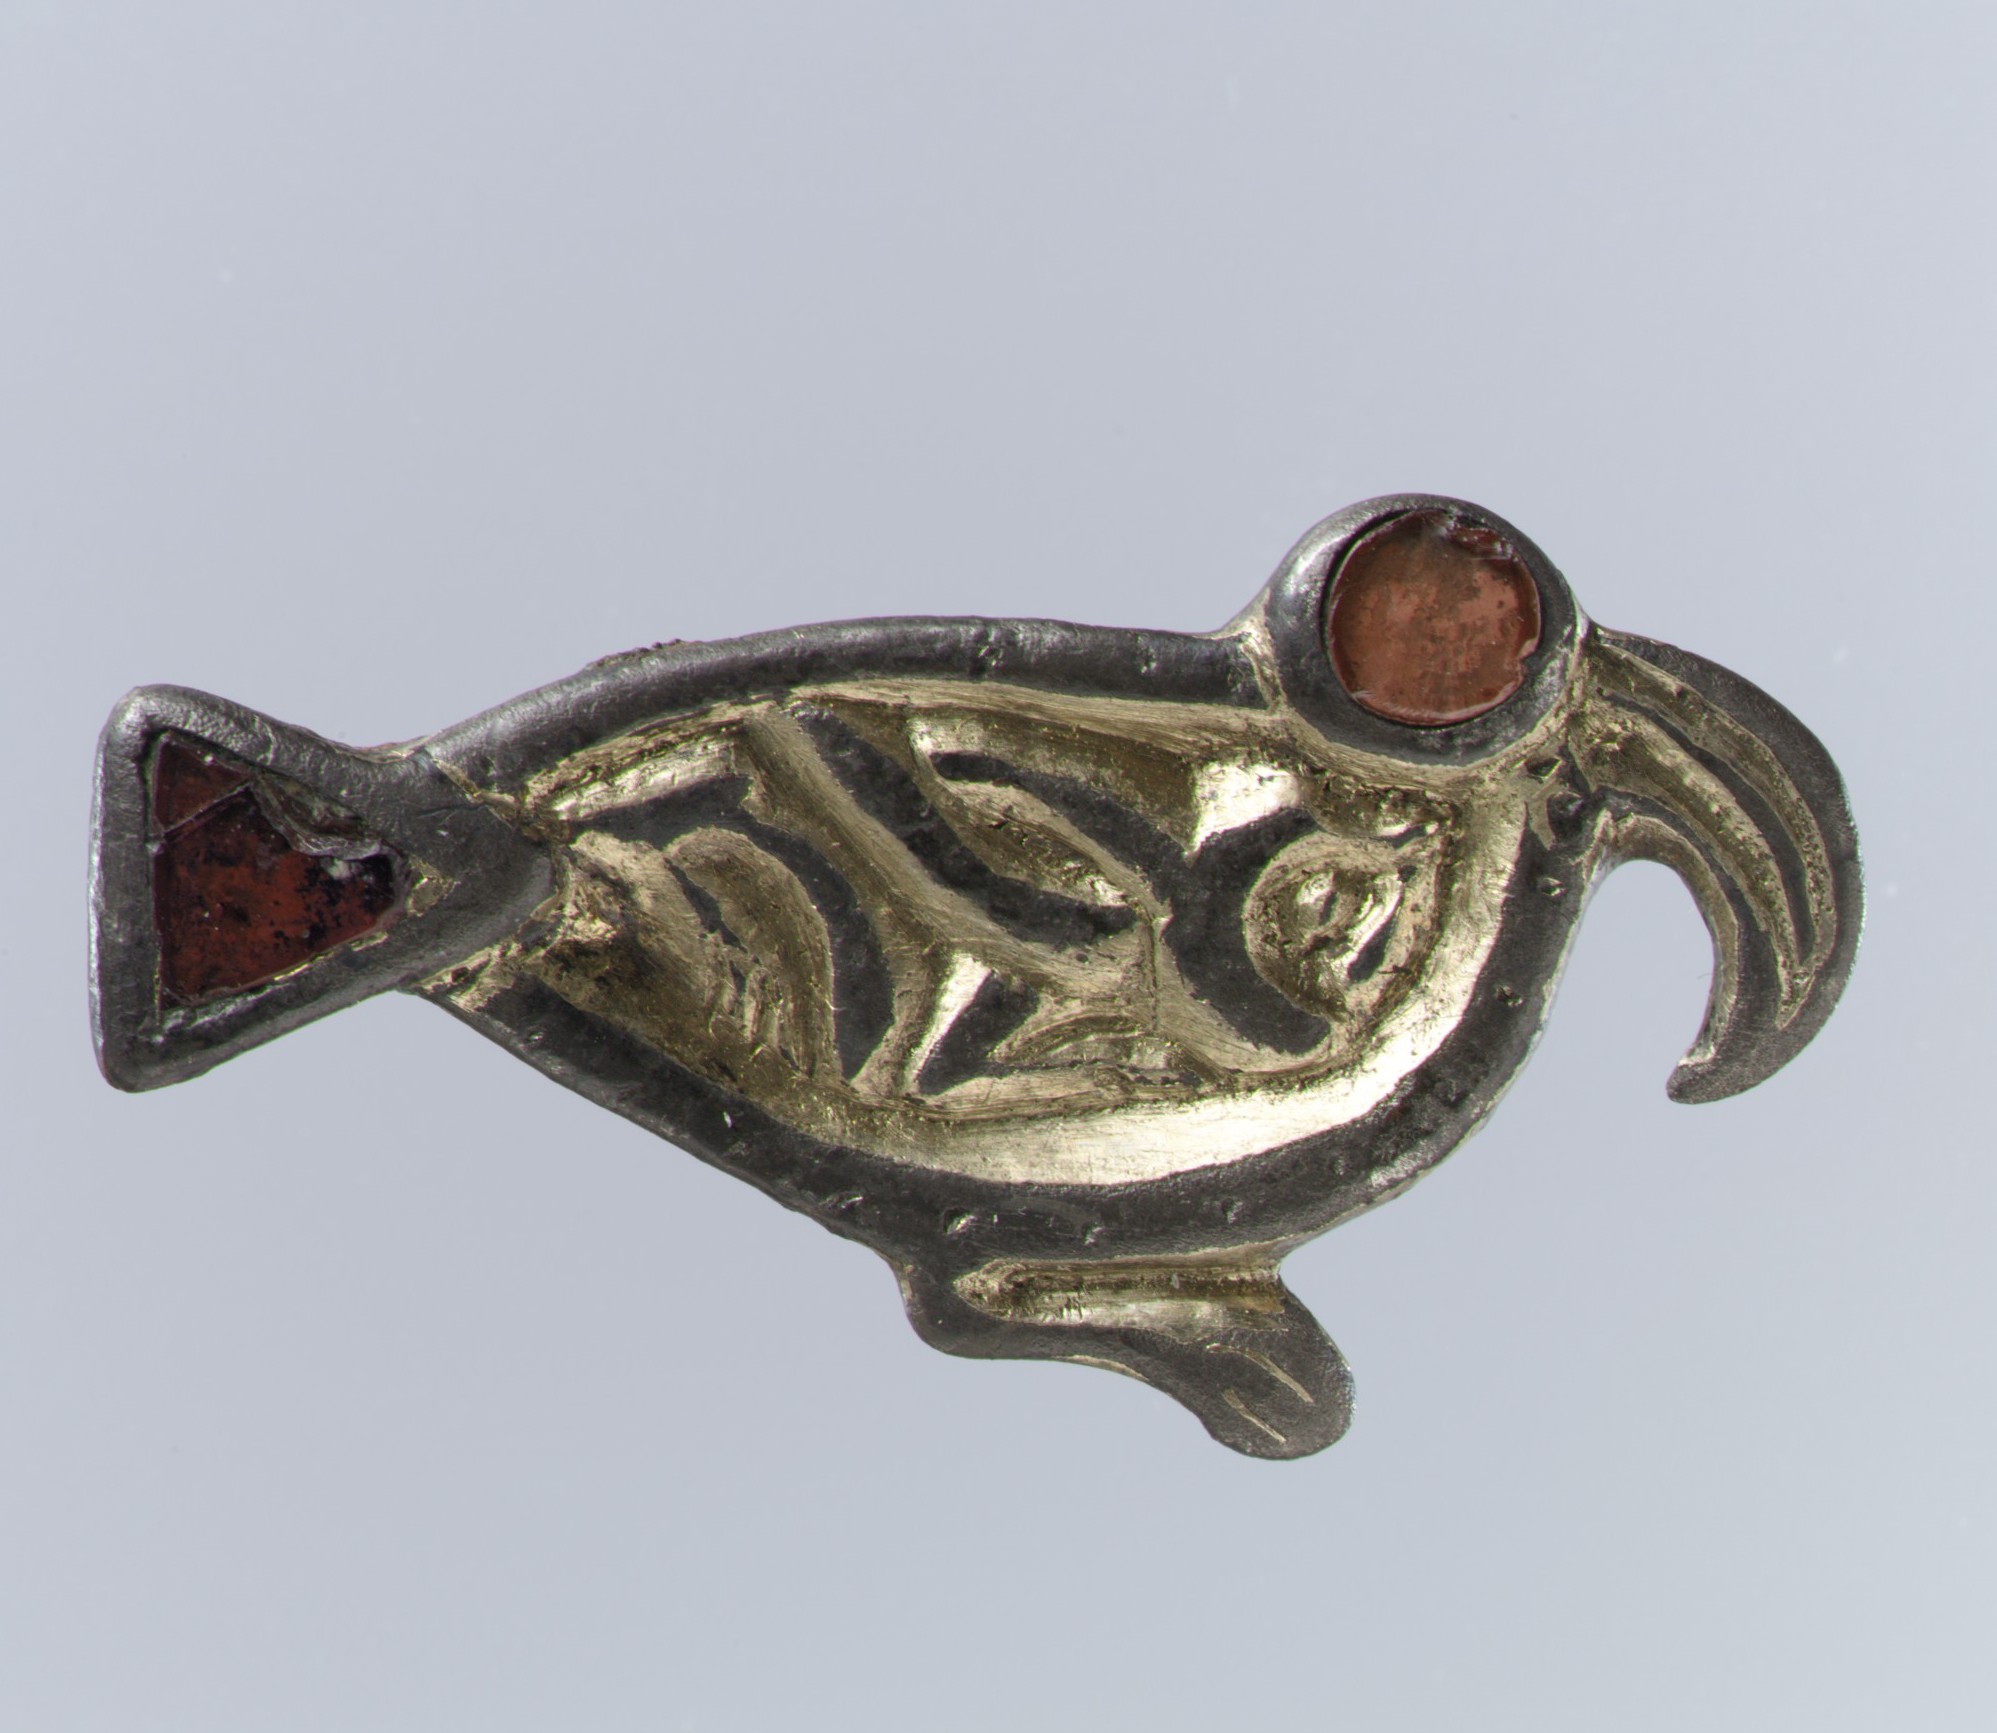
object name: brooch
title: Bird-Shaped Brooch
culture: anglo-saxon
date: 500-550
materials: garnet, silver gilt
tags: birds